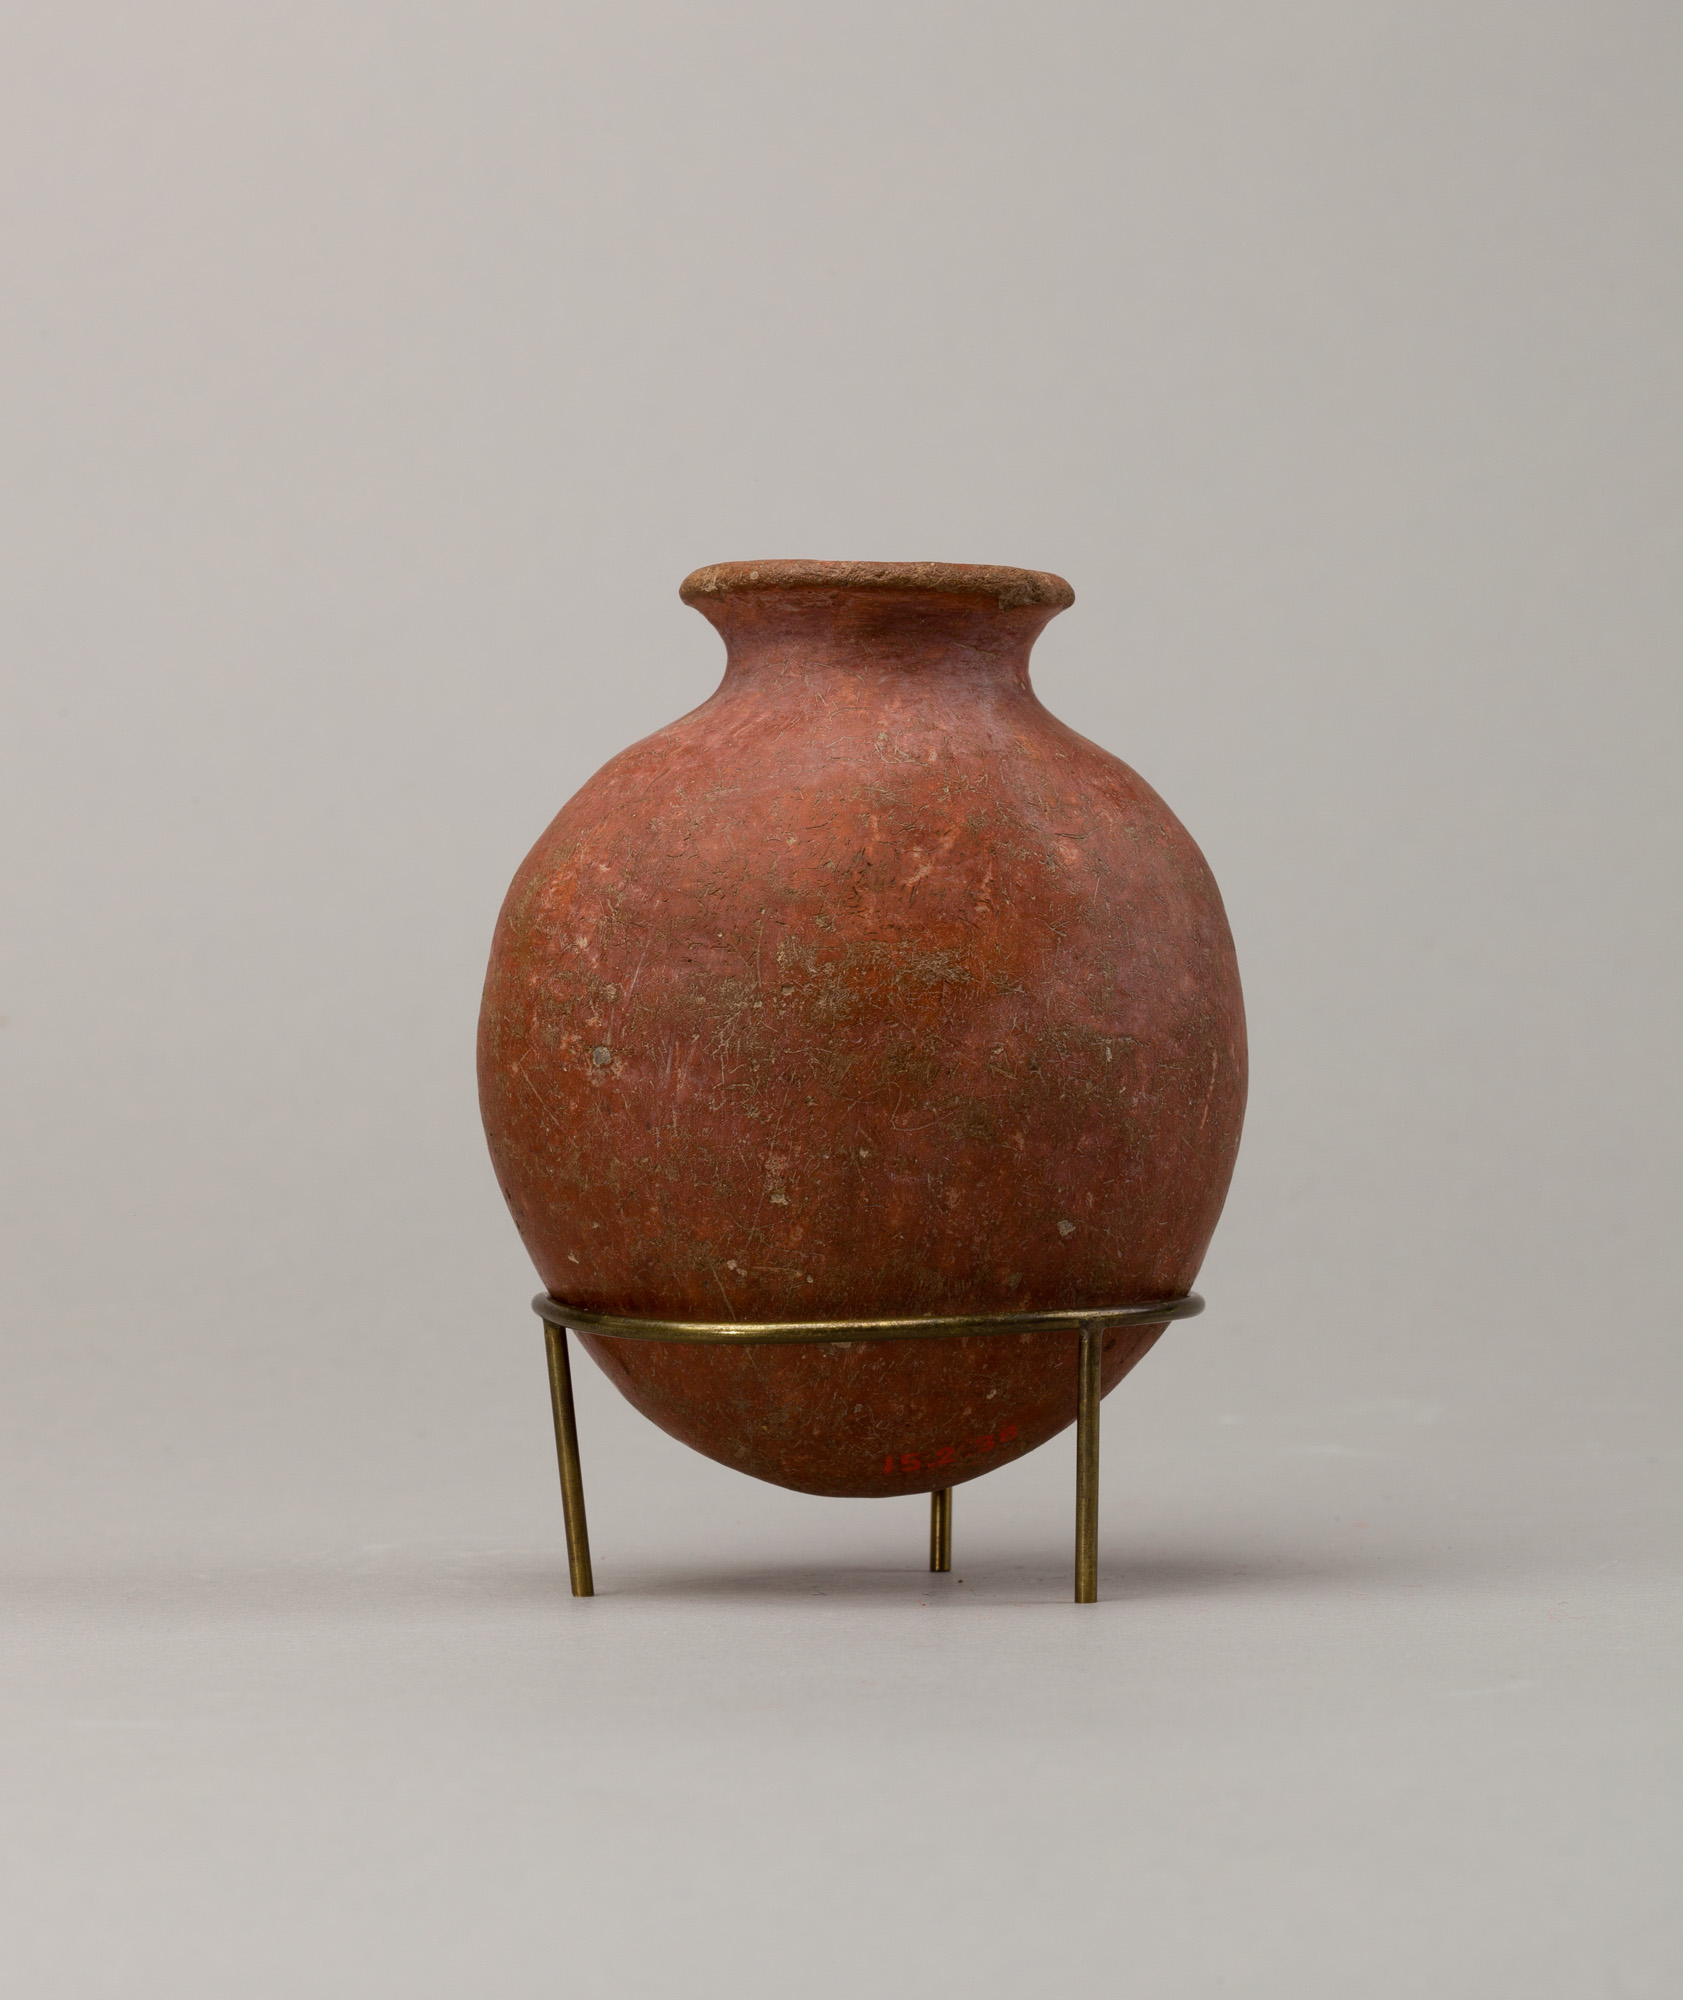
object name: jar, red polished ware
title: Red polished ware jar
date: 3850-2960 BCE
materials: pottery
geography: egypt